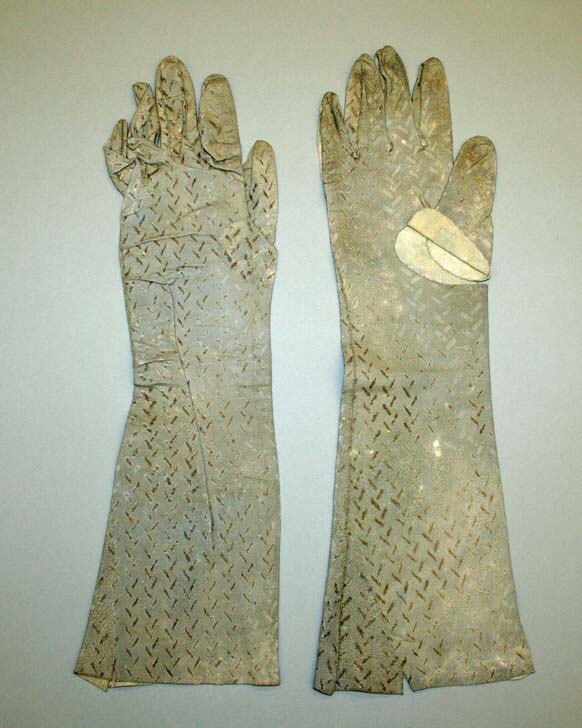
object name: glove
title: Gloves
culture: italian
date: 1767-1833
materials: leather